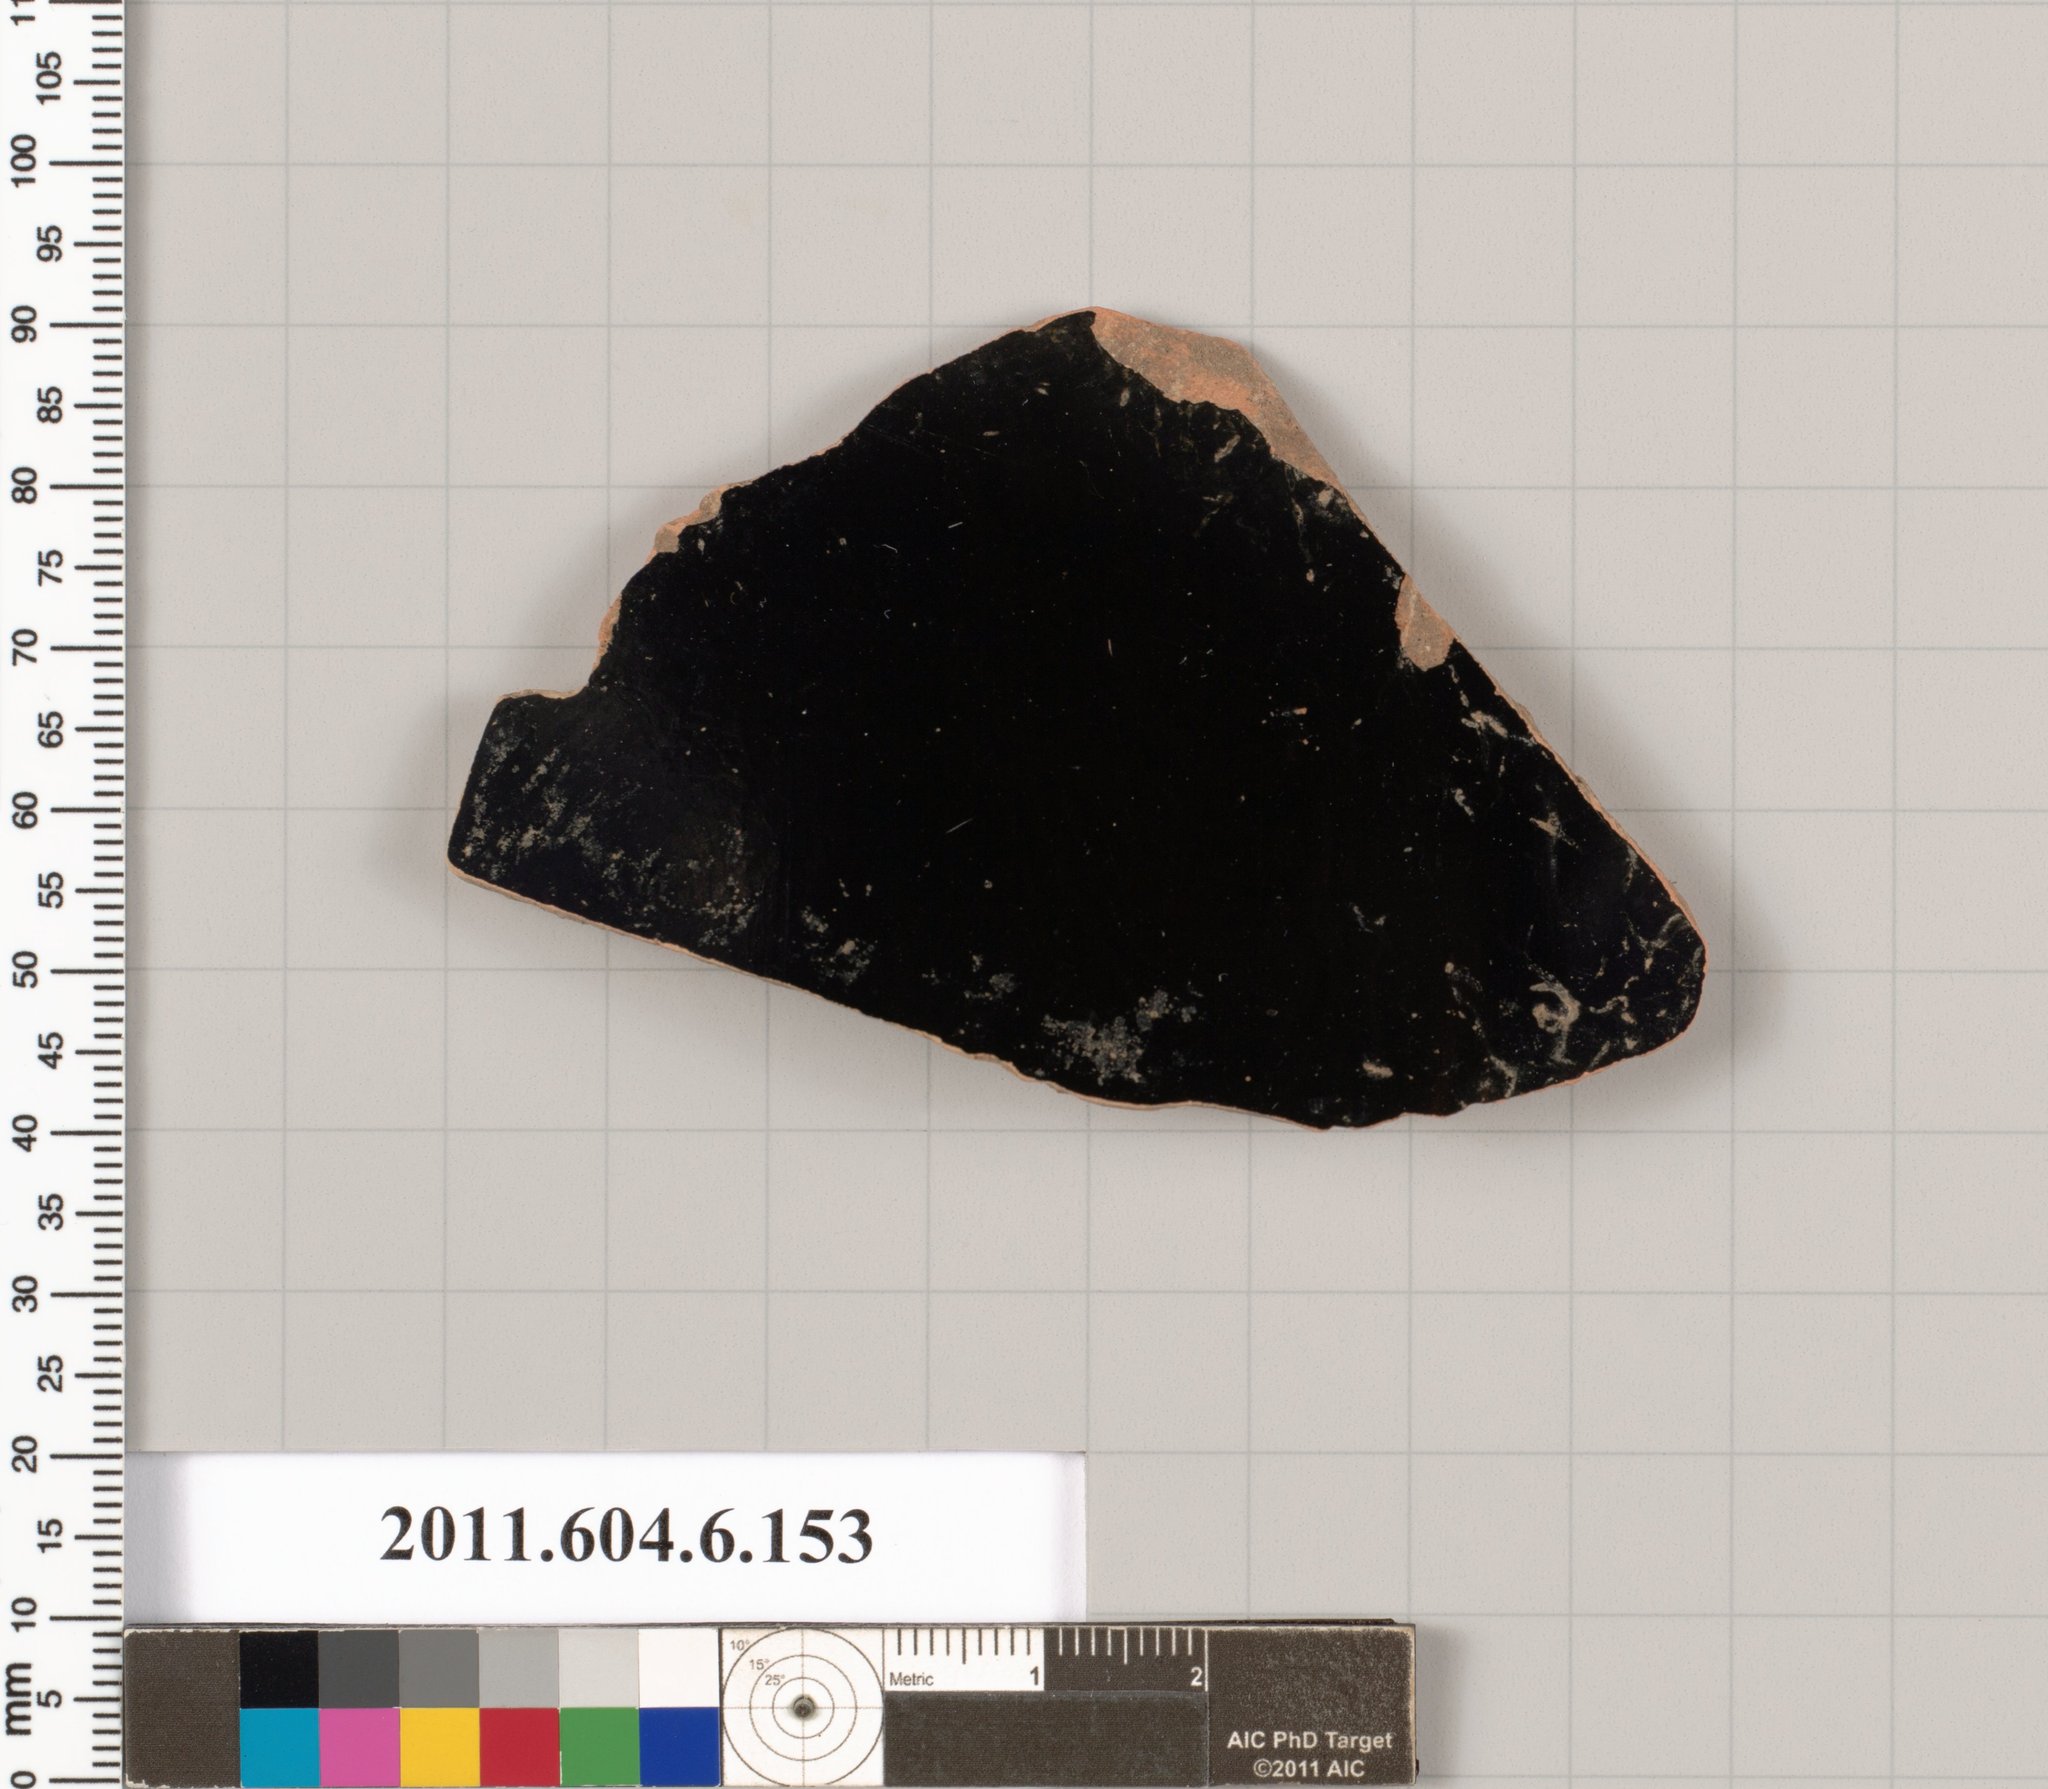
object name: undetermined open shape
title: Terracotta fragment of an open shape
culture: greek, attic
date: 600-401 BCE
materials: terracotta